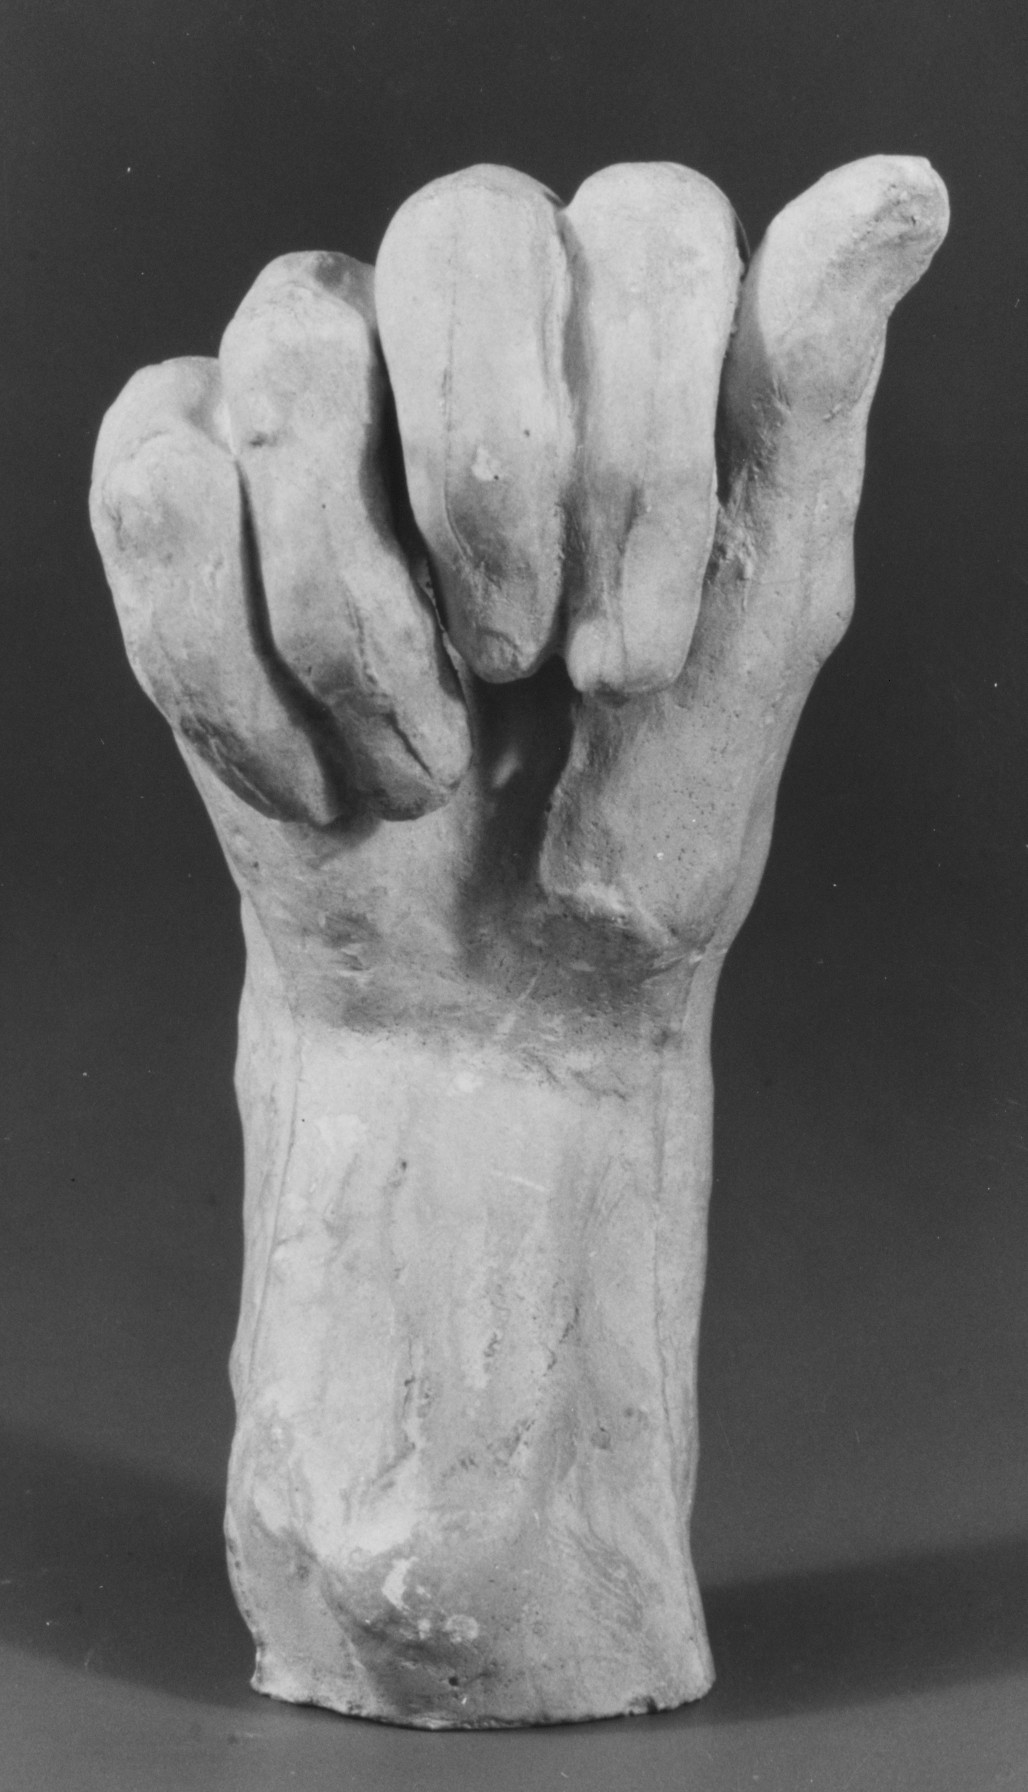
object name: cast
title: Hand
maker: auguste rodin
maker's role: artist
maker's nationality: french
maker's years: 1840-1917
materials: plaster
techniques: casting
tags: hands